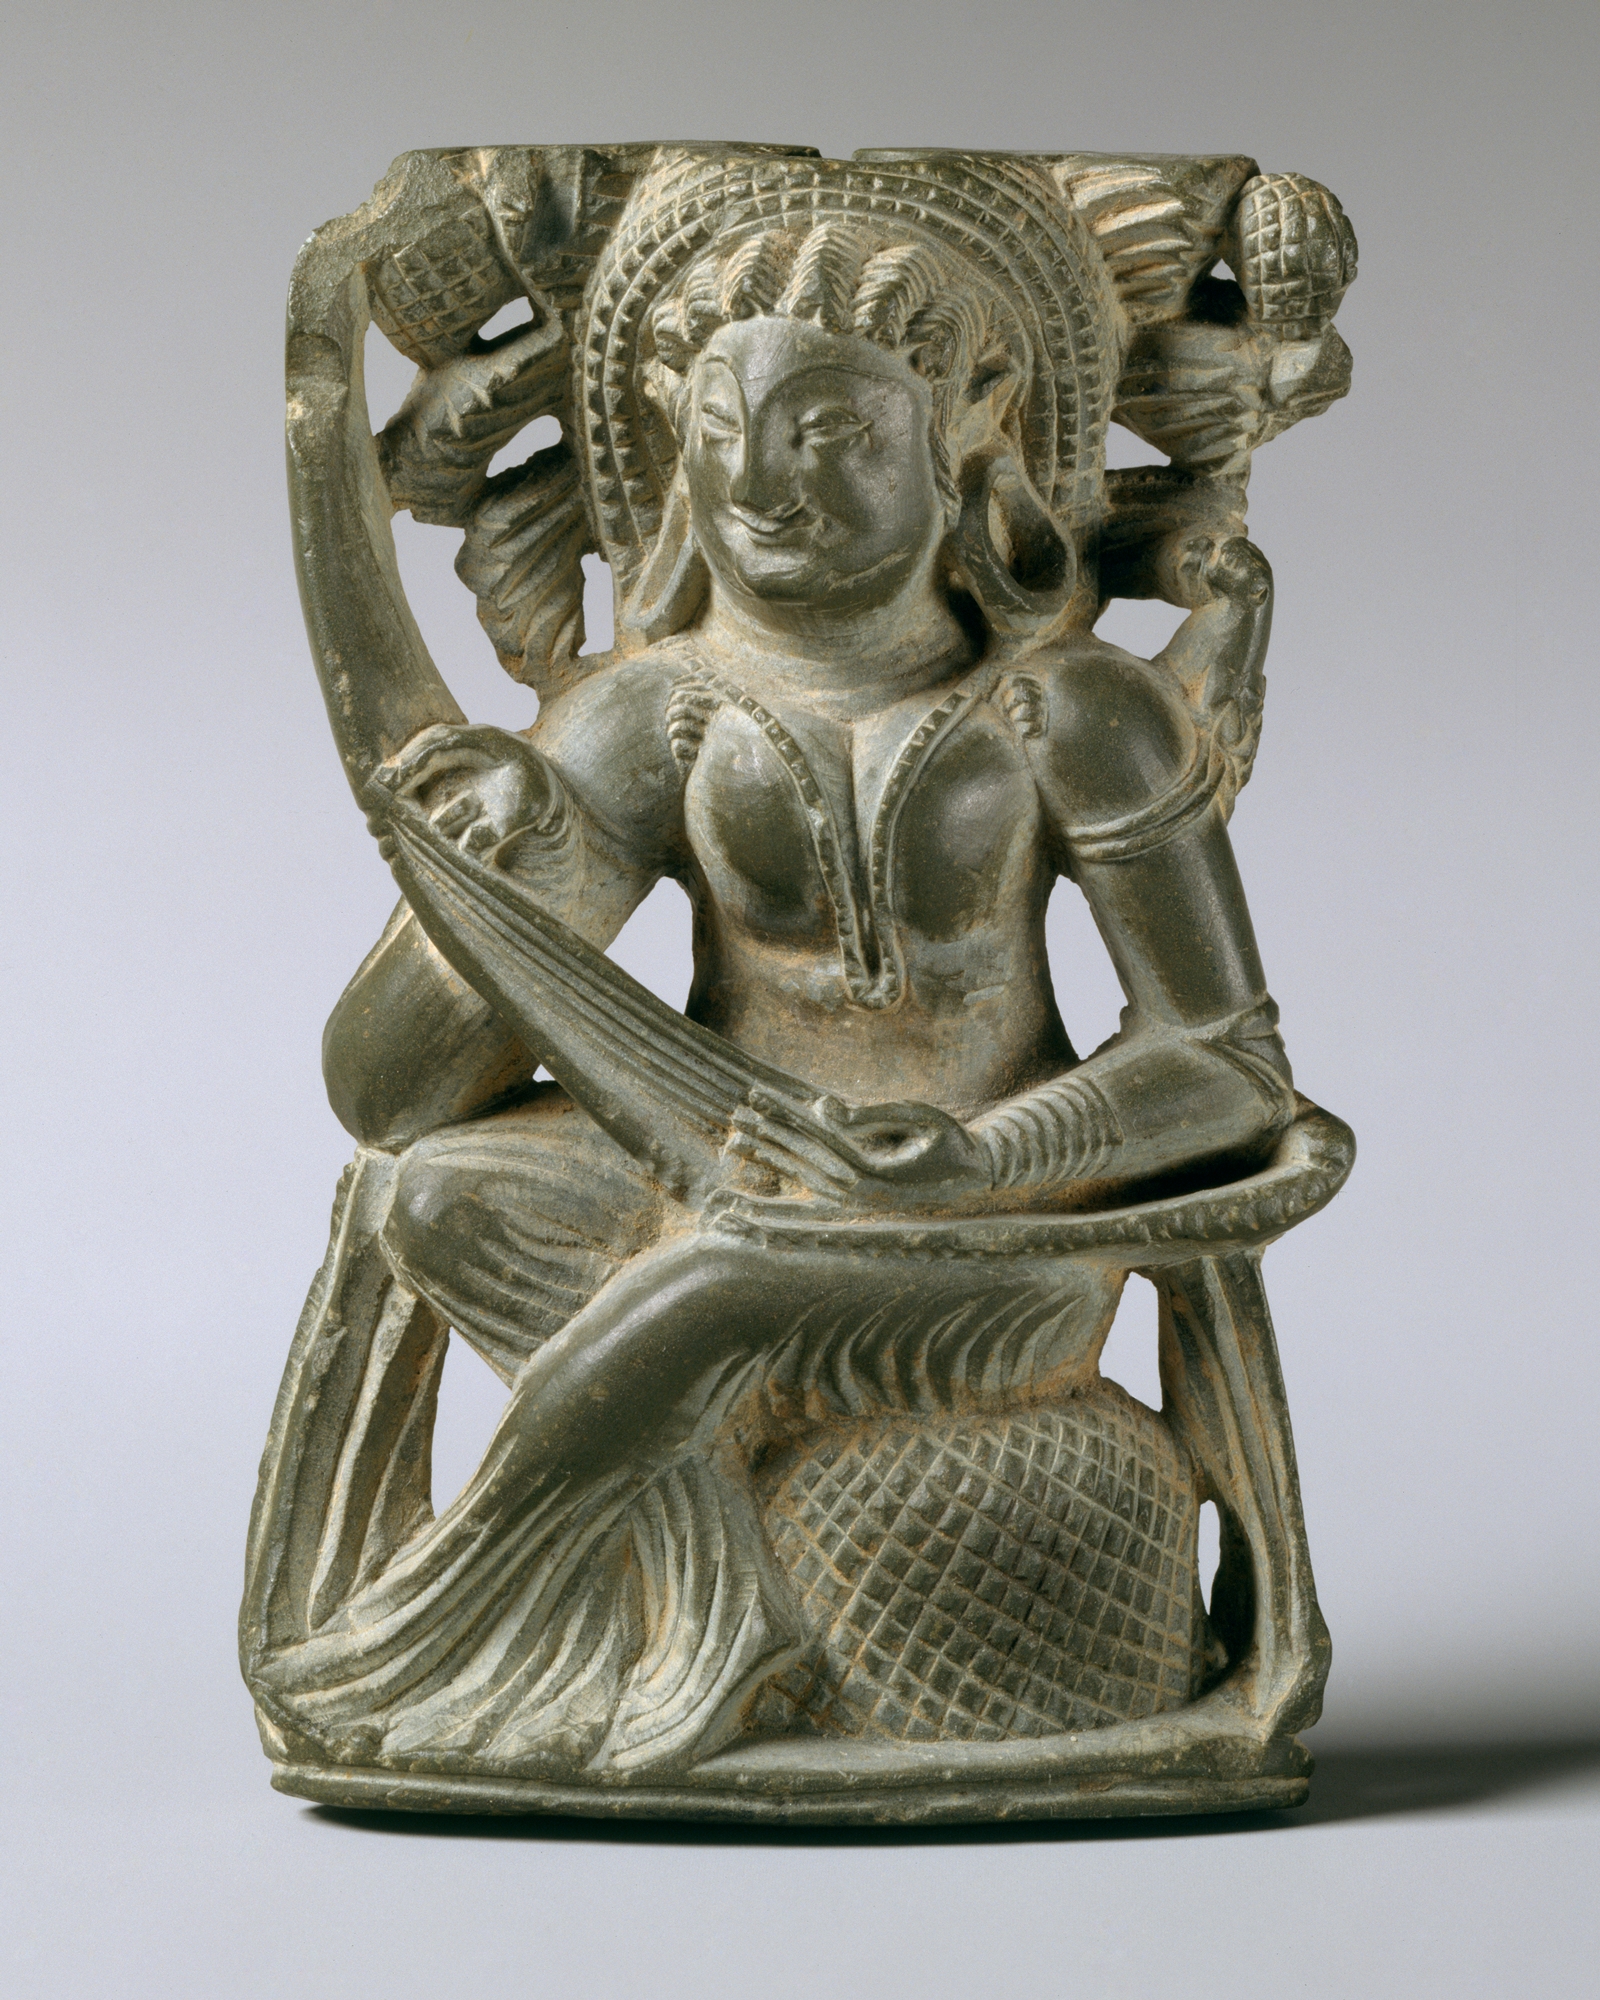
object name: mirror handle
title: Mirror Handle with a Woman Playing the Lute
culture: kashmiri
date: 501-700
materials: mineral, stone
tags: kashmir,women,lutes